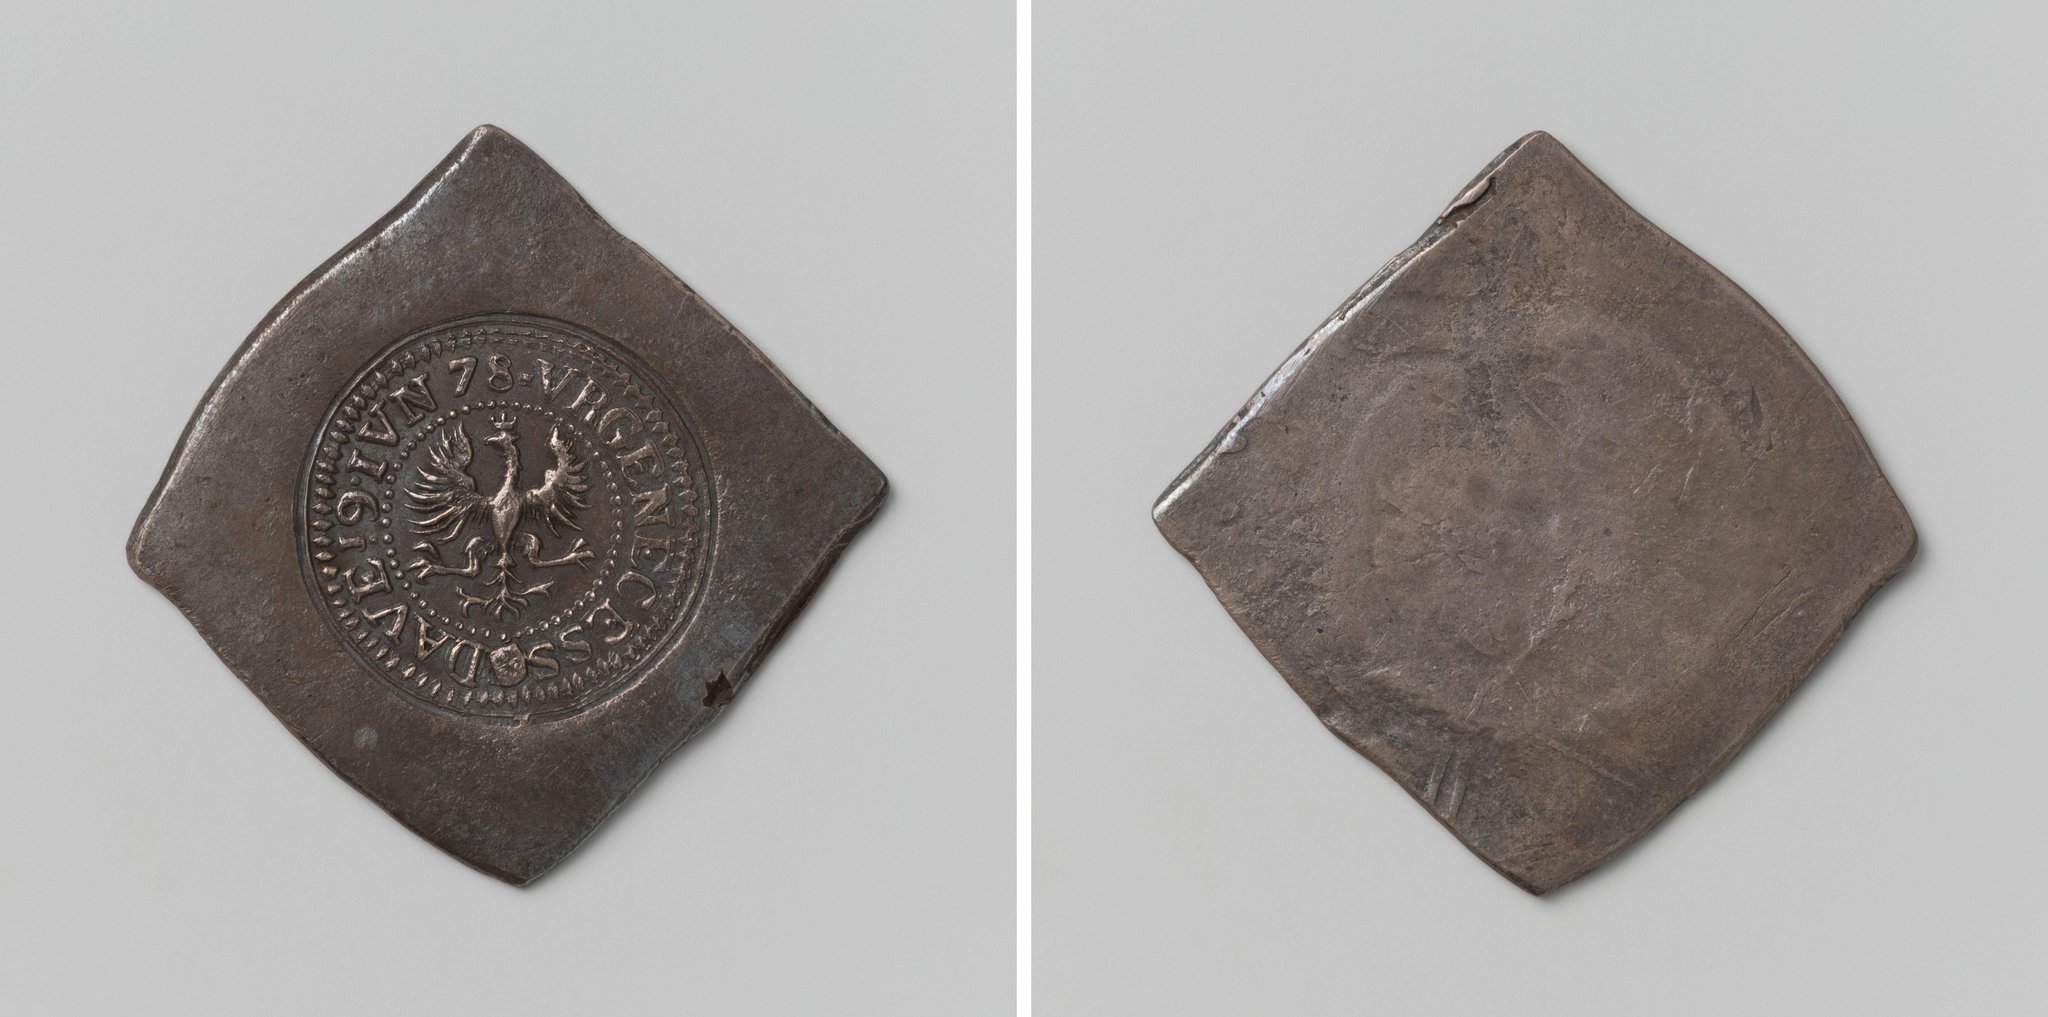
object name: coin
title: Kwart daalder, vervalste noodmunt uit Deventer, geslagen tijdens het beleg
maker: Anonymous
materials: silver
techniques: striking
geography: netherlands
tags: deventer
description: eenzijdige, ruitvormige noodmunt. Voorzijde: gekroonde adelaar binnen omschrift en ronde parelrand. Keerzijde: blanco